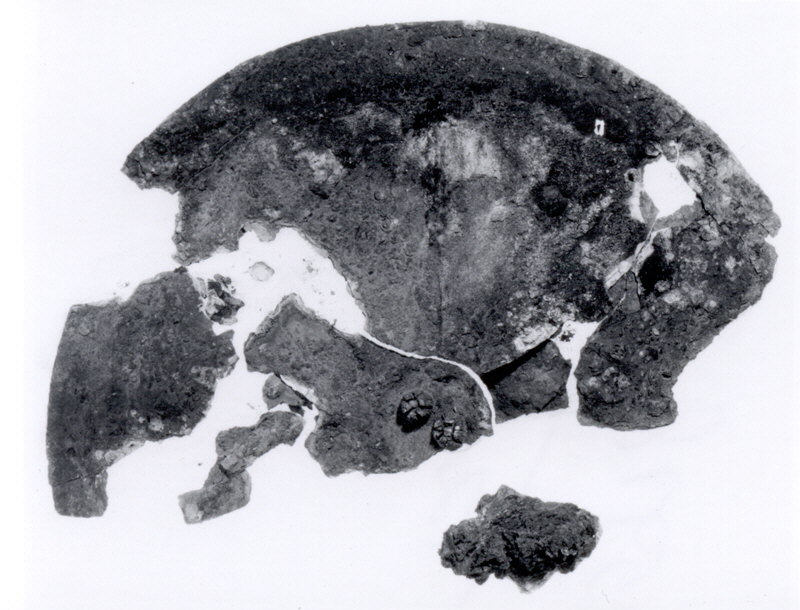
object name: disc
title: Fragmentary disc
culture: iranian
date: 900-801 BCE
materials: bronze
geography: iran